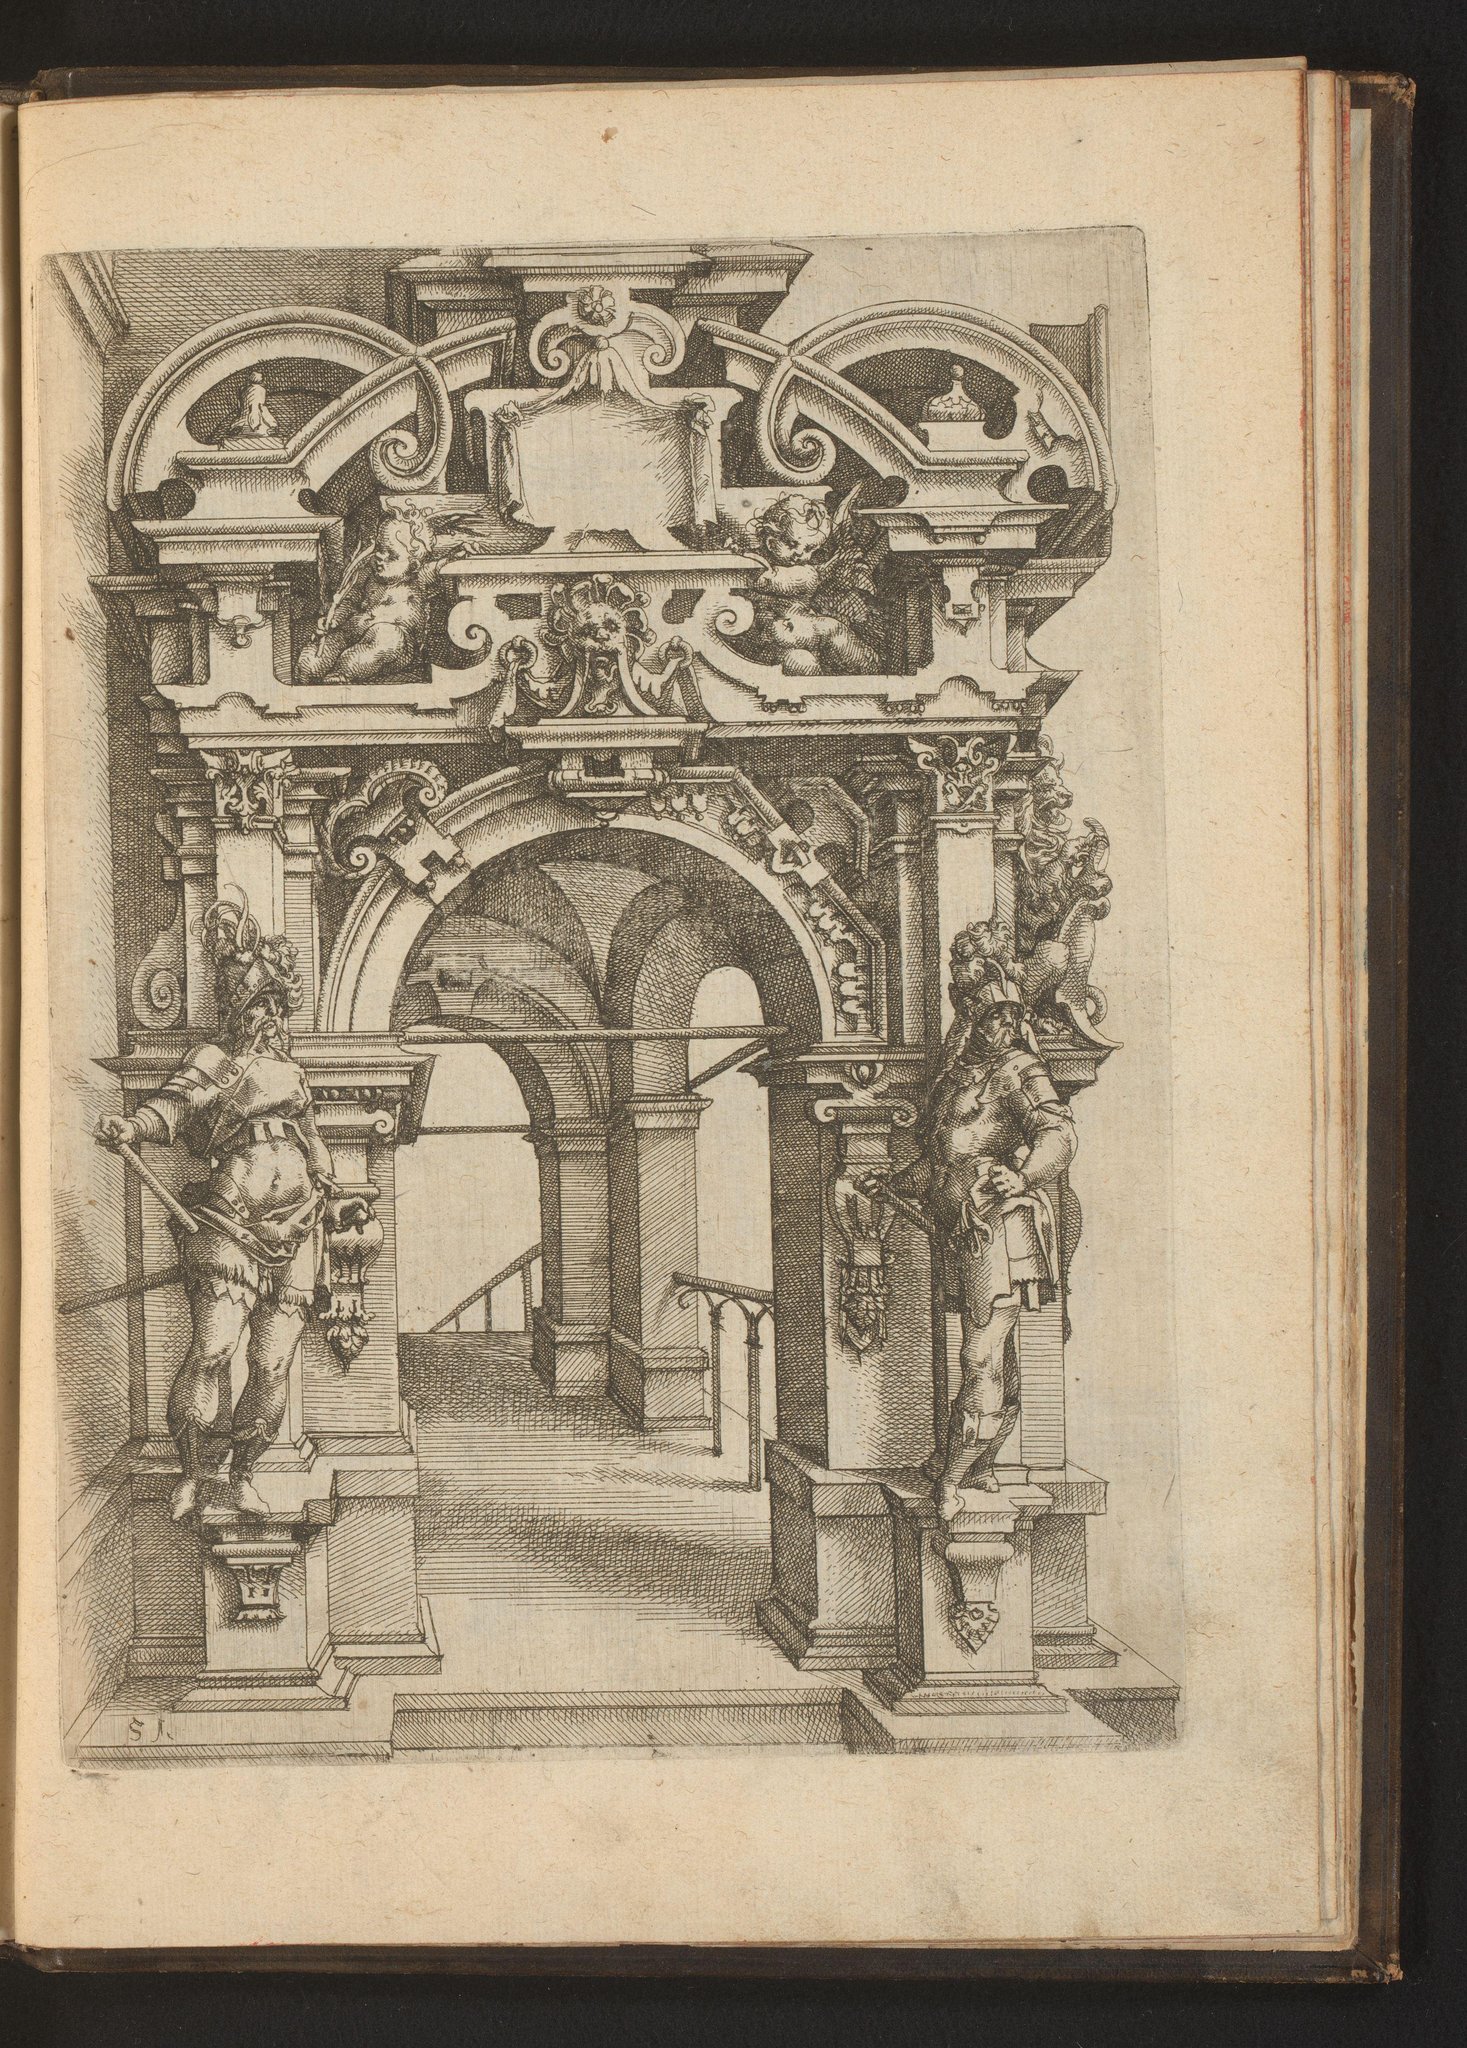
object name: ornament print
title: Architectura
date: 1593-1595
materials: paper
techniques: etching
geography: straatsburg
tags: parts of church exterior and annexes: portal, composite order ~ architecture, private soldier, ornament derived from architectural details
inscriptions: collector's mark: Lugt 2228, collector's mark: Lugt 2760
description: Prent gebruikt in: Dietterlin, Wendel (I). Wendel Dietterlin, Architectura de Polstium seu Portalium ornatu uario Liber II. Straatsburg: Bernhard Jobin, 1594.